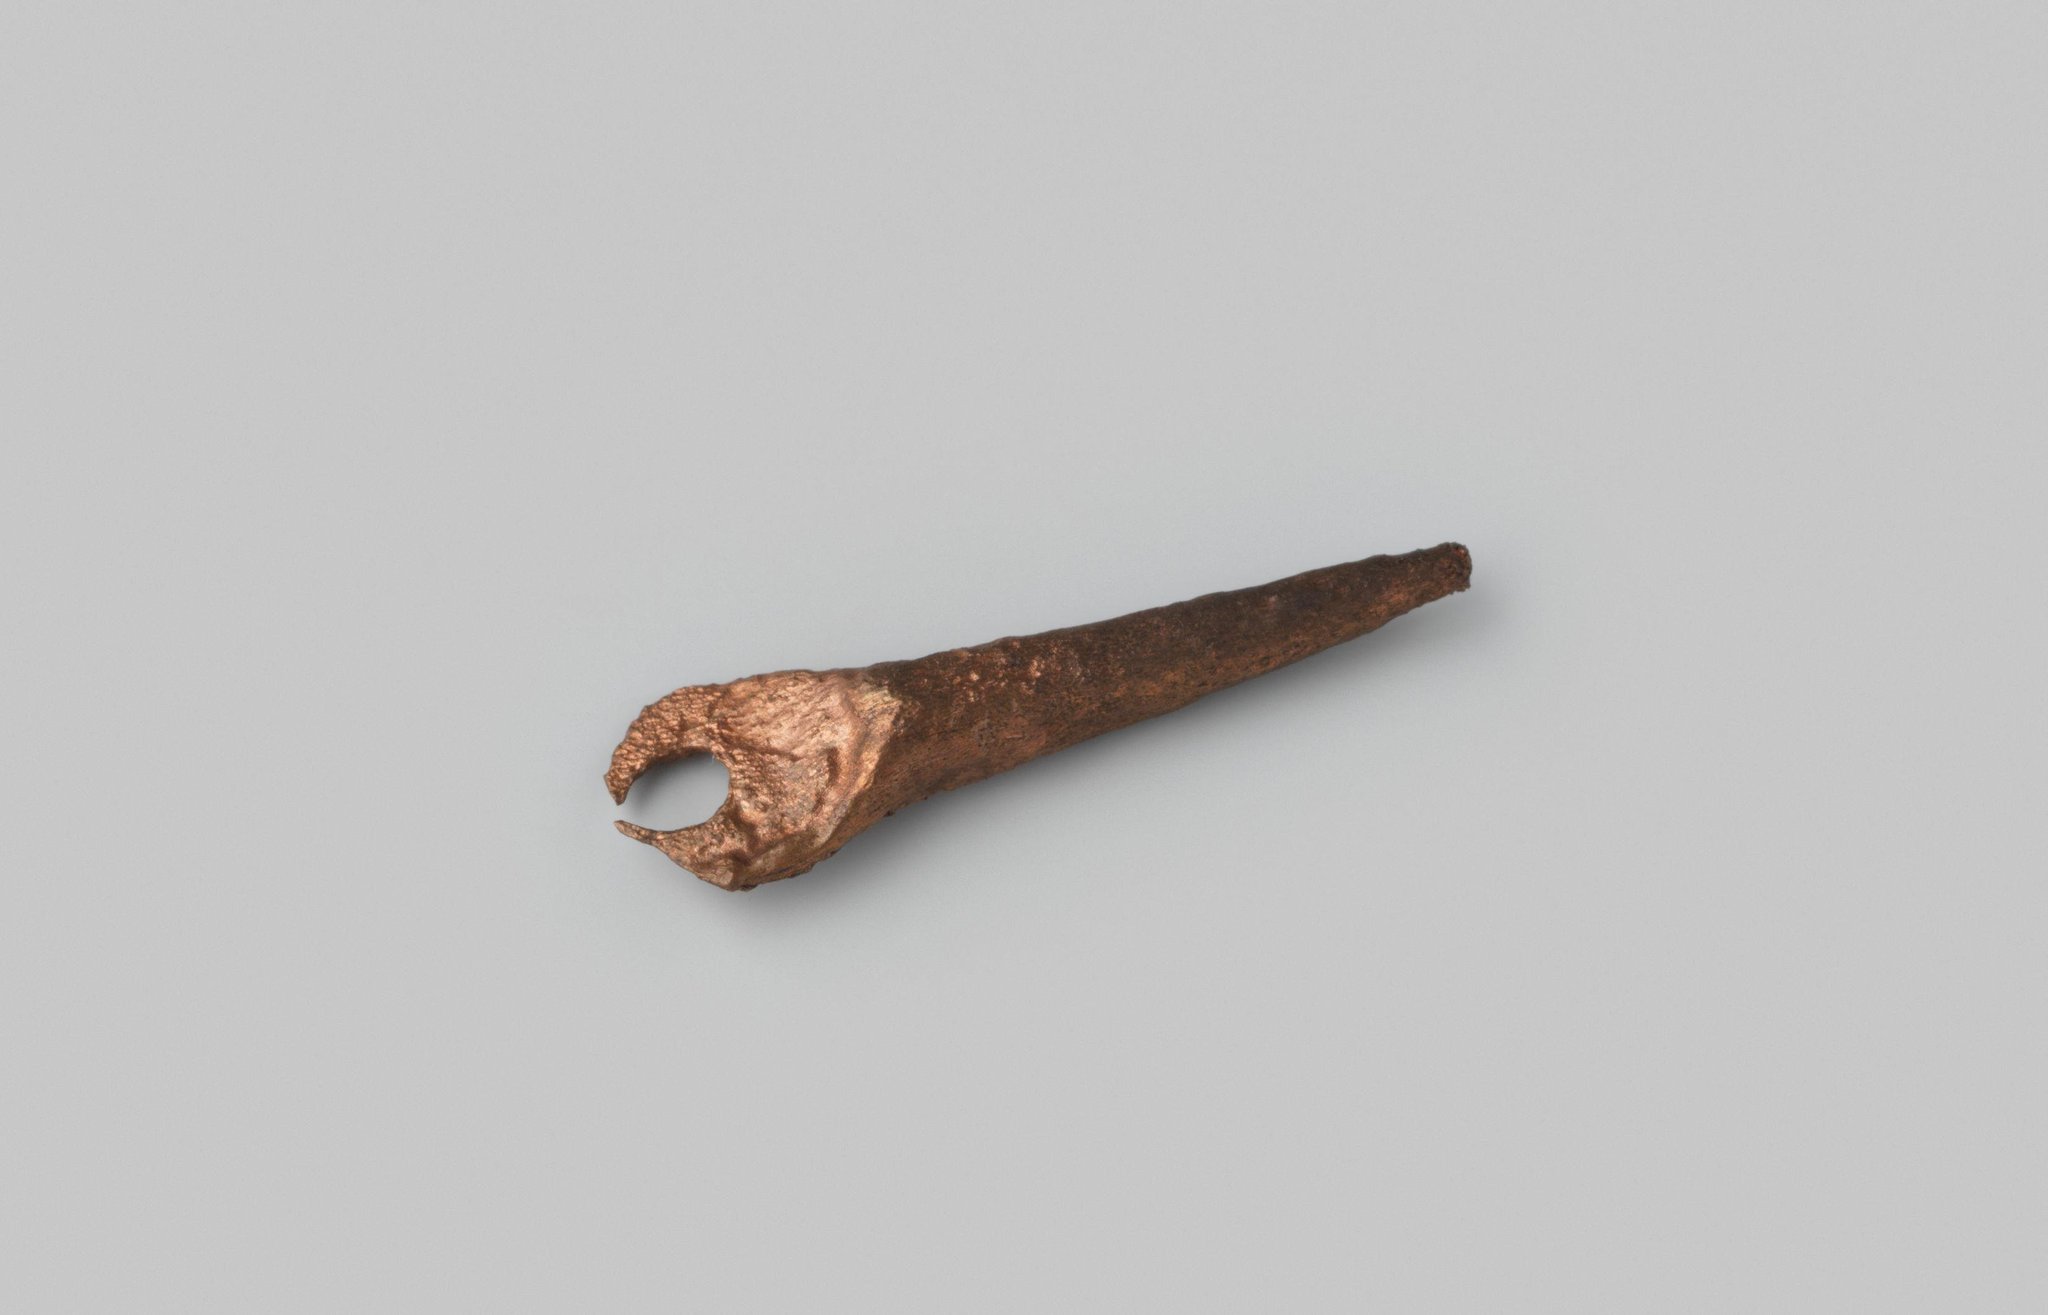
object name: wedge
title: Wig uit het wrak van de Oost-Indiëvaarder Hollandia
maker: Anonymous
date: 1700-1743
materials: copper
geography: netherlands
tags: verenigde oostindische compagnie, hollandia (schip), annet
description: Locks, fastenings and accesories, wedge; id. NG 1980-27H1492, eroded.